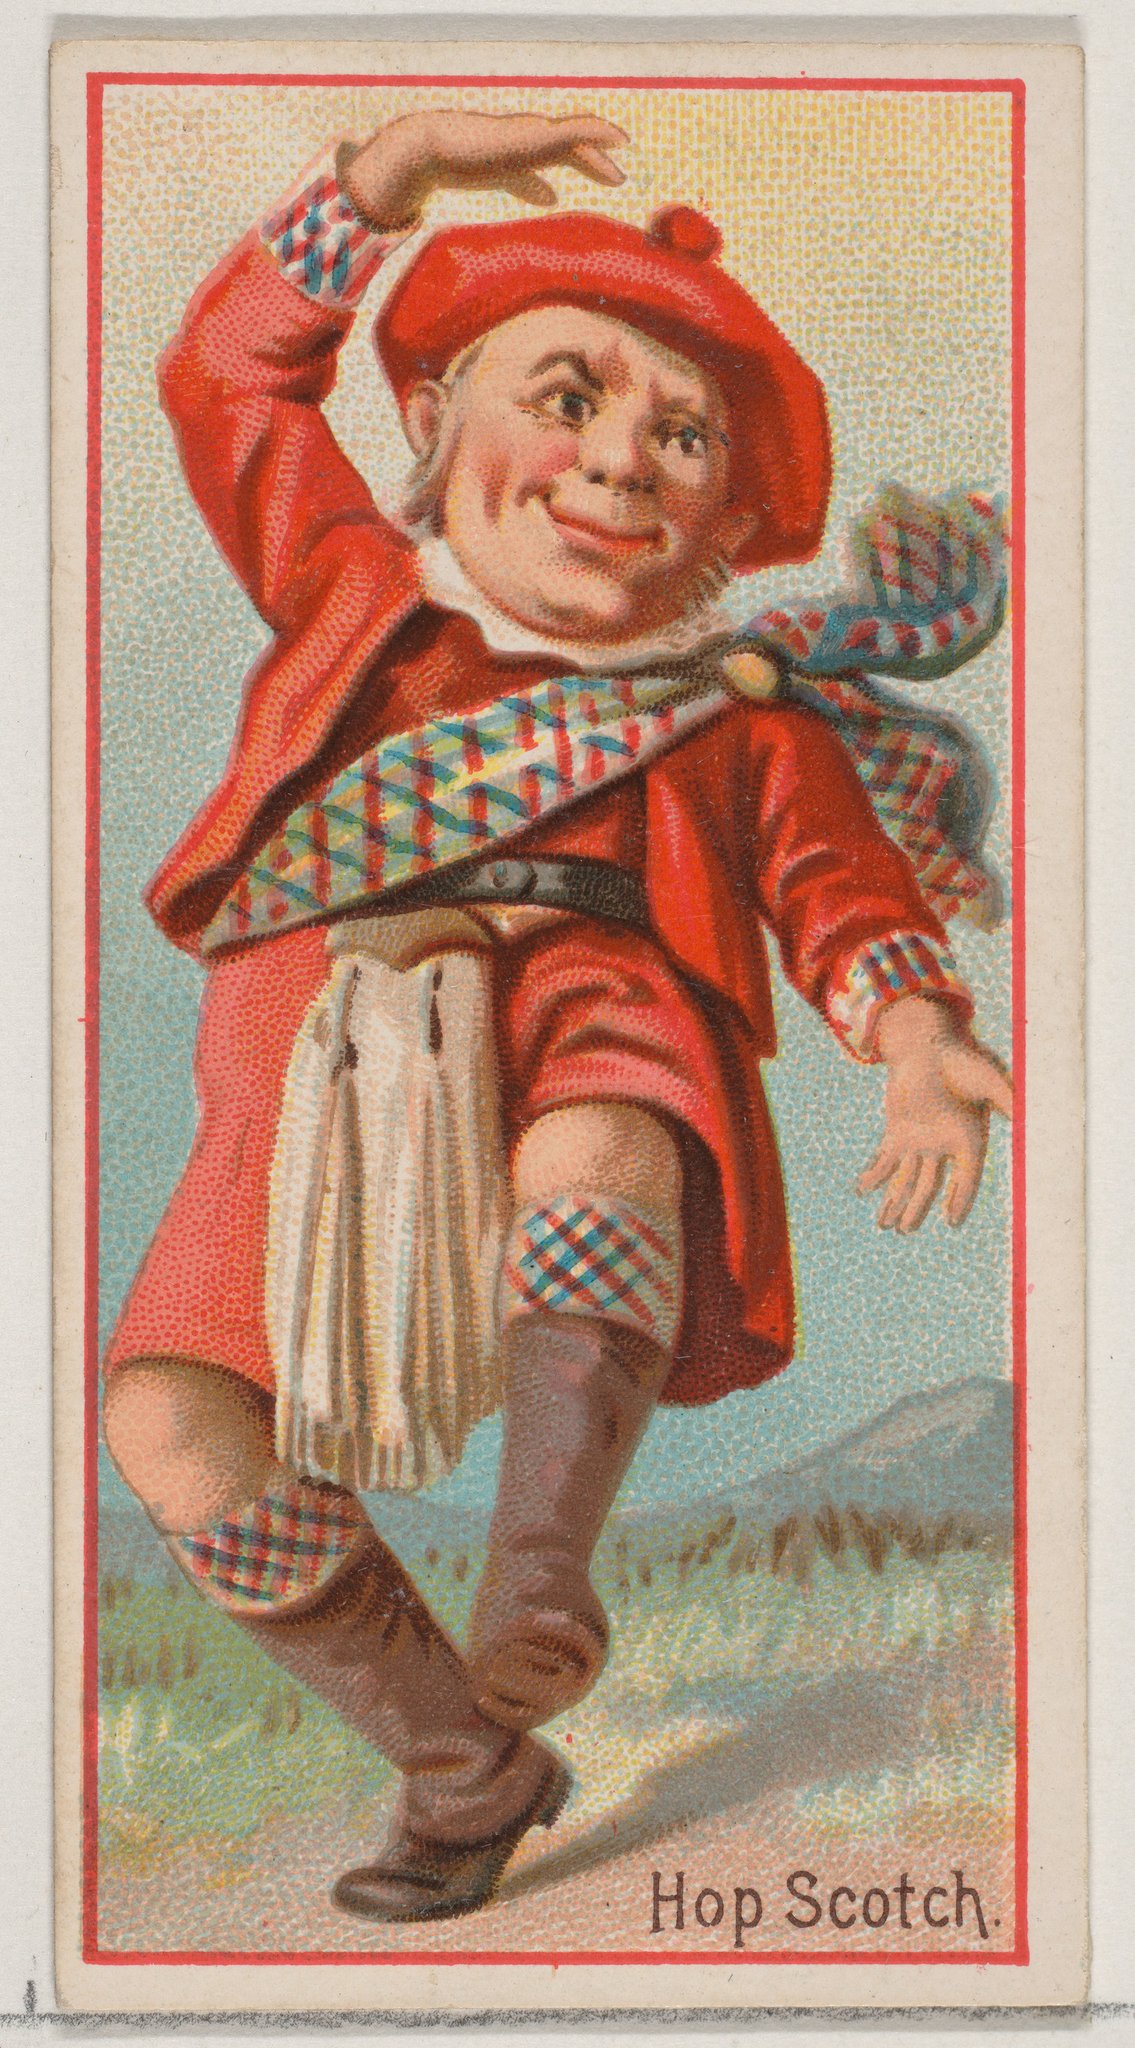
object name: print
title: Hopscotch, from the Jokes series (N87) for Duke brand cigarettes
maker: w. duke, sons & co.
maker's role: publisher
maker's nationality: american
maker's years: 1870-1920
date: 1890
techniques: color lithograph